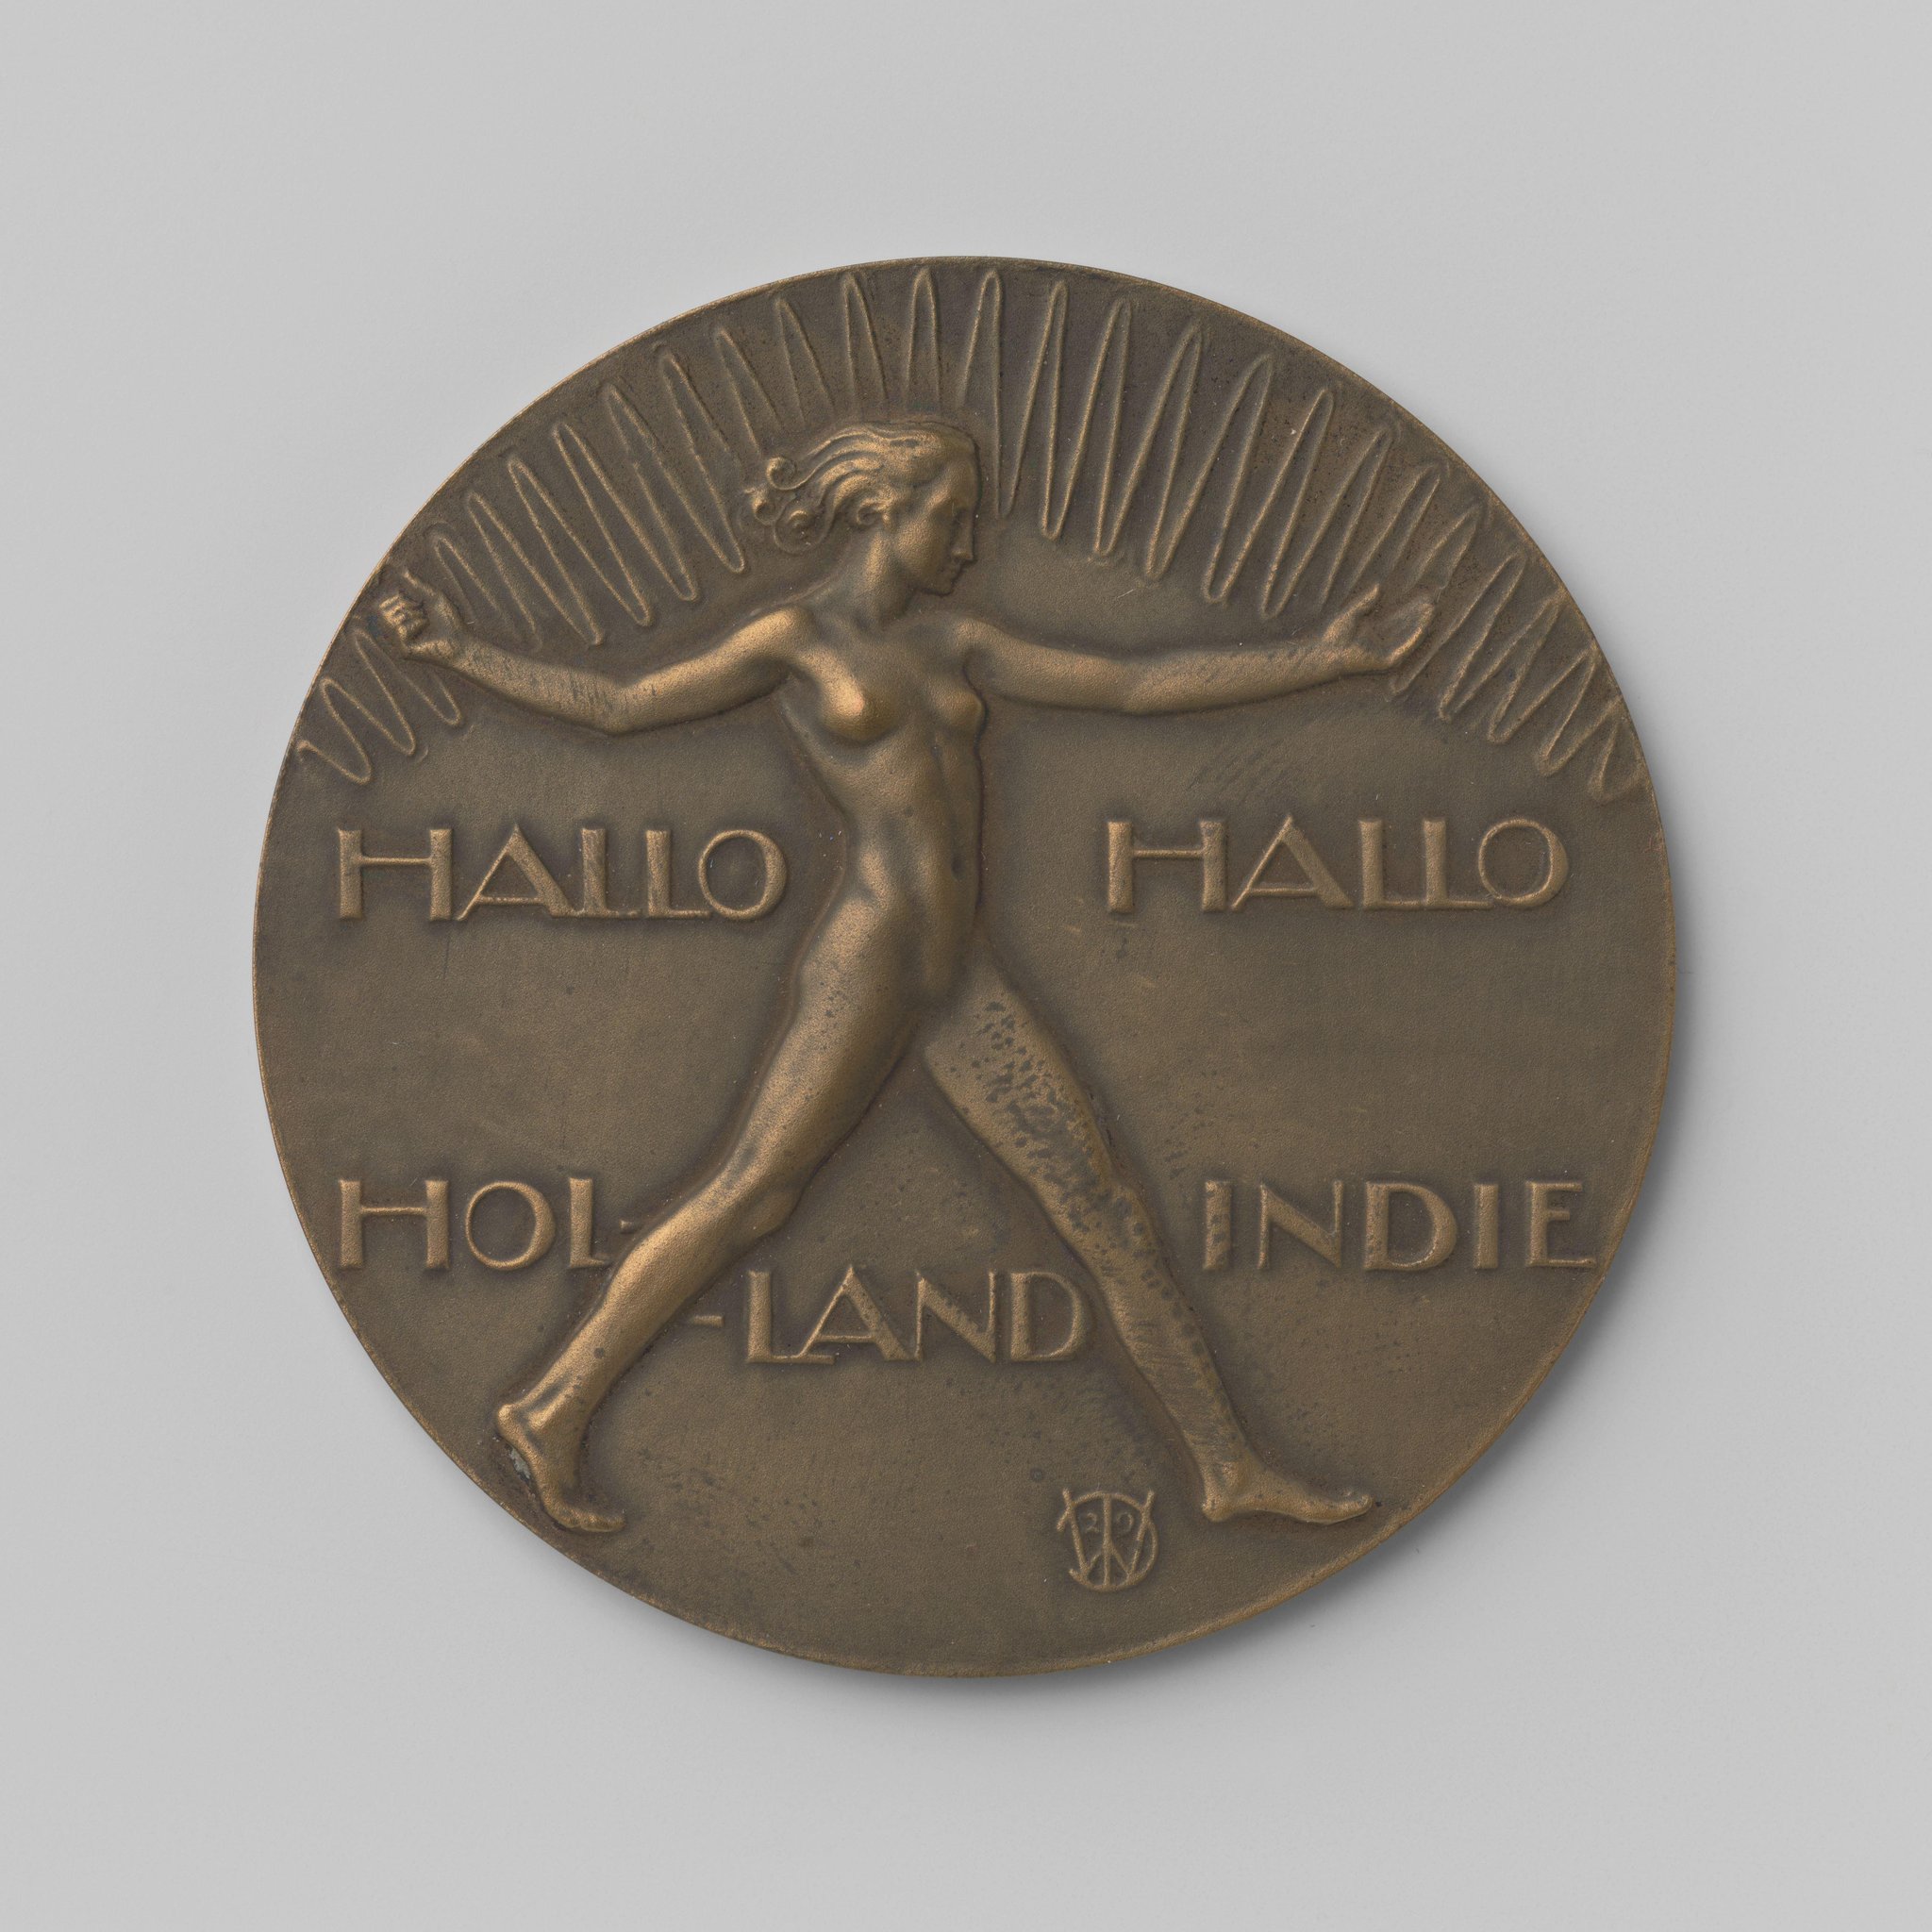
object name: history medal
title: Eerste radiotelefonische verbinding tussen Nederland en Indië (Vereniging voor Penningkunst 1929, eerste penning)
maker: dirk wolbers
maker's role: designer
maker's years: 1890-1957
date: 1929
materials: bronze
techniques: striking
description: Bronzen penning, op de voorzijde een vrouw met gespreide armen voortschrijdend onder een golflijn, in het veld twee regels tekst, op de keerzijde een schematische stroomkring met condensator waaronder zes regels tekst, met verklaring.